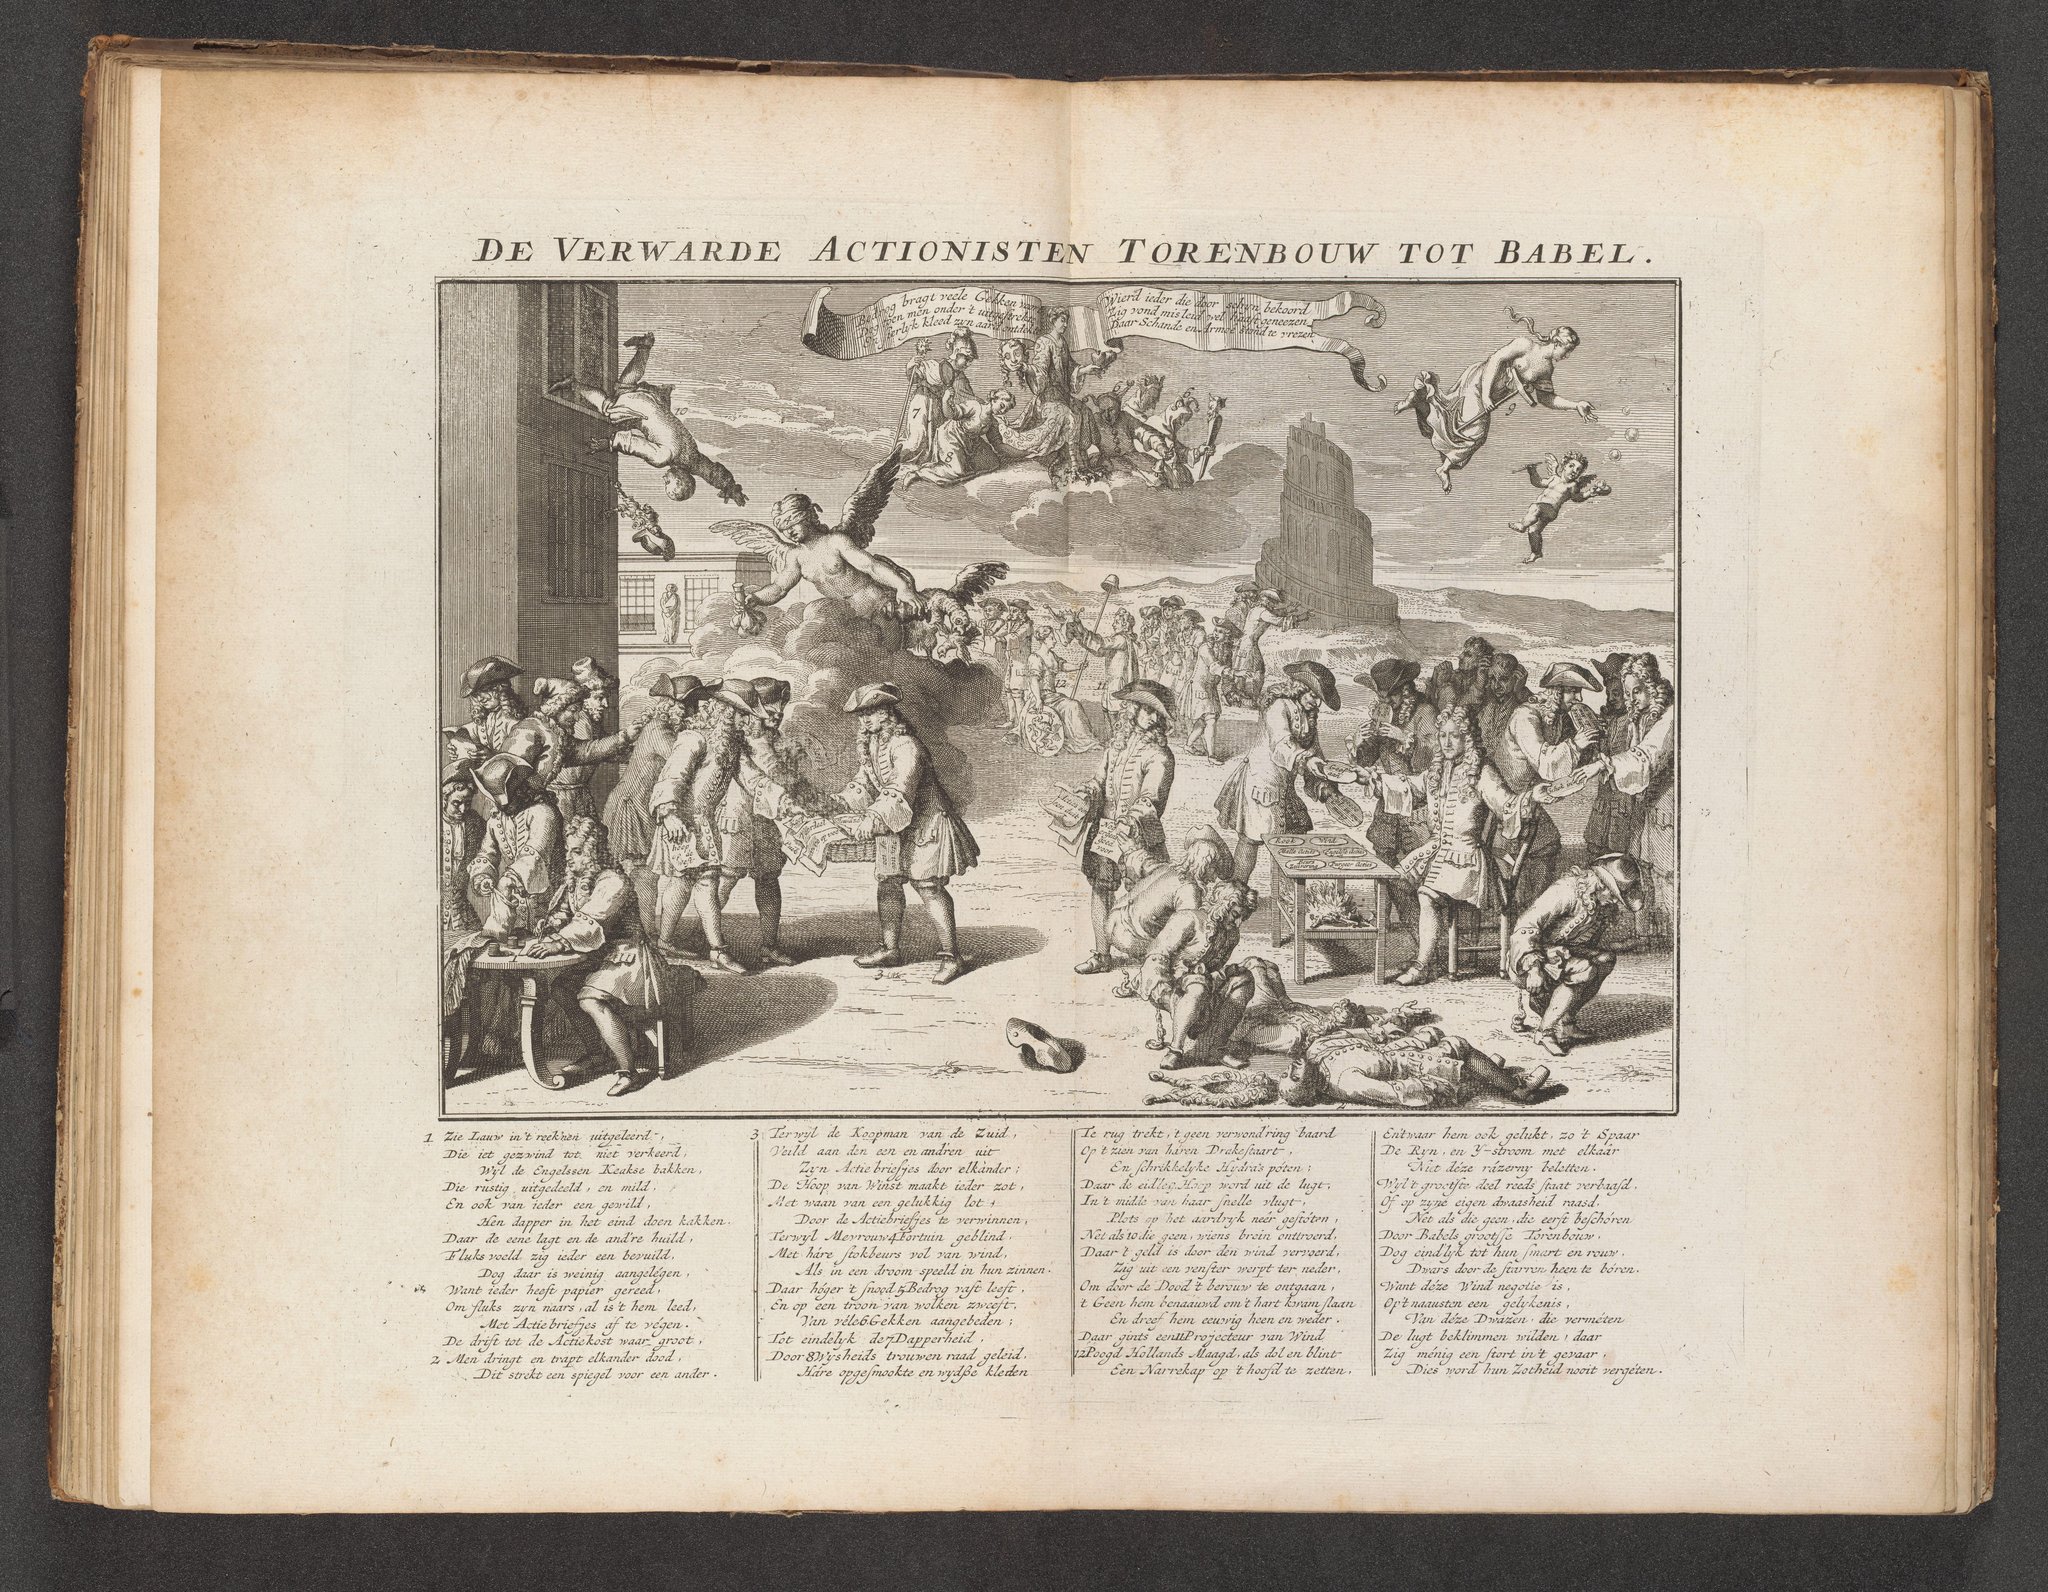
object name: print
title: Het Groote Tafereel der Dwaasheid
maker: Anonymous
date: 1720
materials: paper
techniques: etching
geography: northern netherlands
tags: the tower of babel, defecation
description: Spotprent op de Actionisten en de toren van Babel. John Law zit links aandelen uit de schrijven terwijl windhandelaren zich te goed doen aan door de Engelsen gebakken kaakjes. De handelaren raken door deze koeken aan de diarree, de waardeloze aandelen gebruiken ze om hun achterste mee af te vegen. In de voorstelling vele ander details met Fortuna, de Nederlandse Maagd, de Hoop etc. In het onderschrift een vers in 4 kolommen waarin de cijfers uit de voorstelling worden verklaard. Prent in de gebonden vierde uitgave (304 B 12) van Het Groote Tafereel der Dwaasheid met spotprenten op de Windhandel of Actiehandel van 1720.